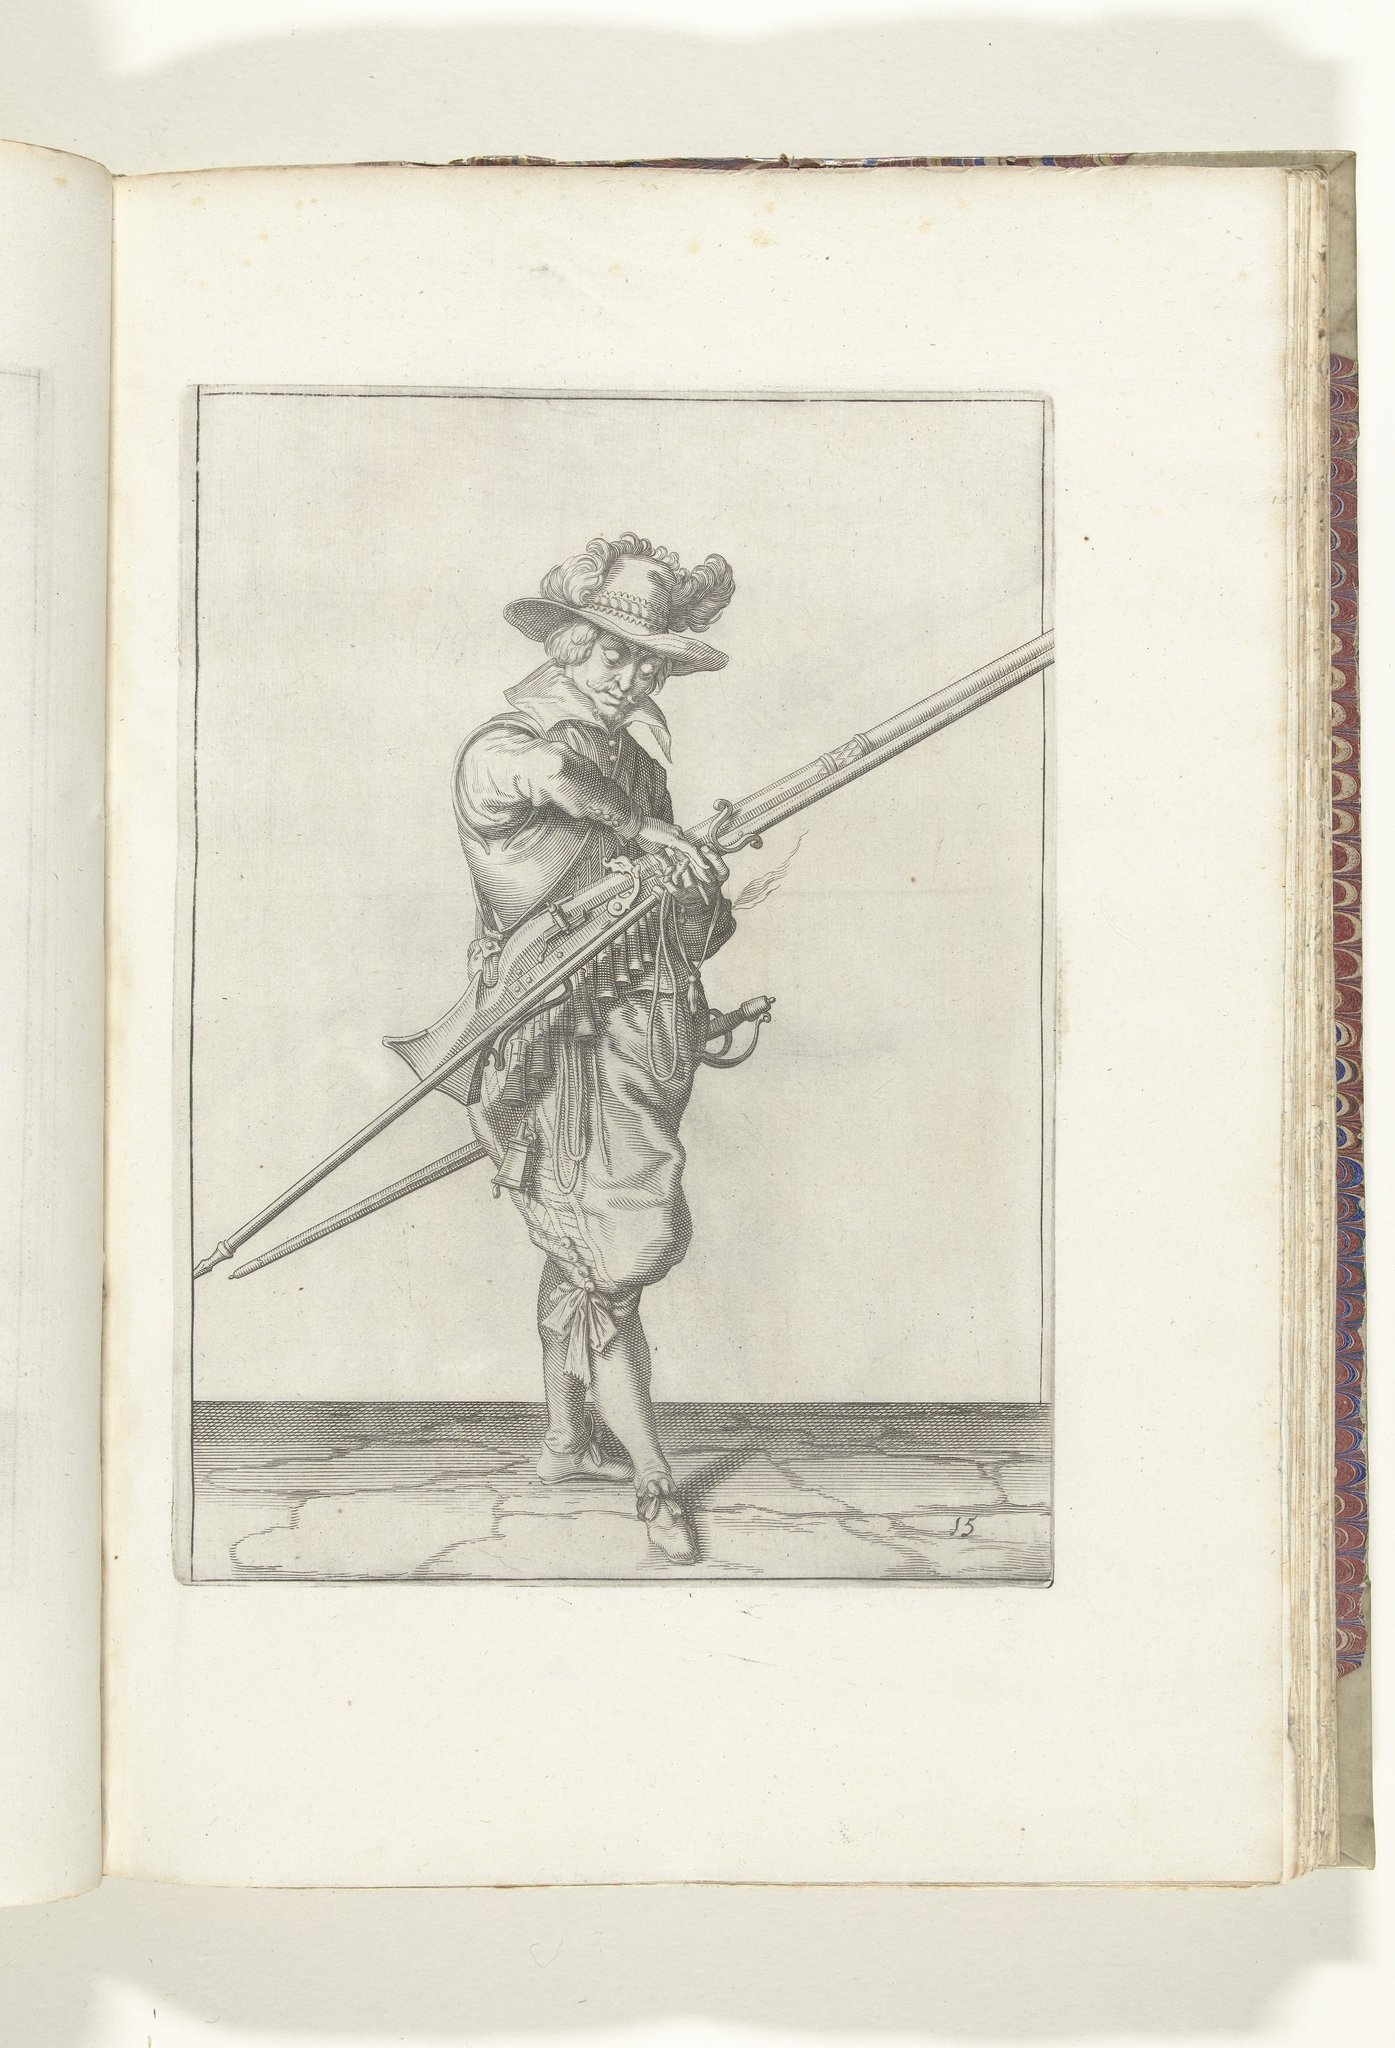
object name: print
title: Soldaat met een musket die zijn lont overbrengt van zijn rechter- naar zijn linkerhand (nr. 15), ca. 1600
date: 1597-1607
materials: paper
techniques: engraving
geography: amsterdam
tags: maurice (prince of orange), handling of weapons ~ military training, weapons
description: Een soldaat, ten voeten uit, naar rechts, die een musket (een bepaald type vuurwapen) en een furket (musketvork) met zijn linkerhand vasthoudt (nr. 15), ca. 1600. De brandende lont in zijn rechterhand brengt hij over naar zijn linkerhand. Plaat 15 in de instructies voor het hanteren van het musket: Corte onderrechtinghe op de figuerlicke afbeeldinghe, soo veel aengaet het recht ghebruyck van Musquet. Onderdeel van de illustraties in: J. de Gheyn, Wapenhandelinghe van Roers Musquetten ende spiessen, Amsterdam, 1608. Krijgswezen rond 1600.